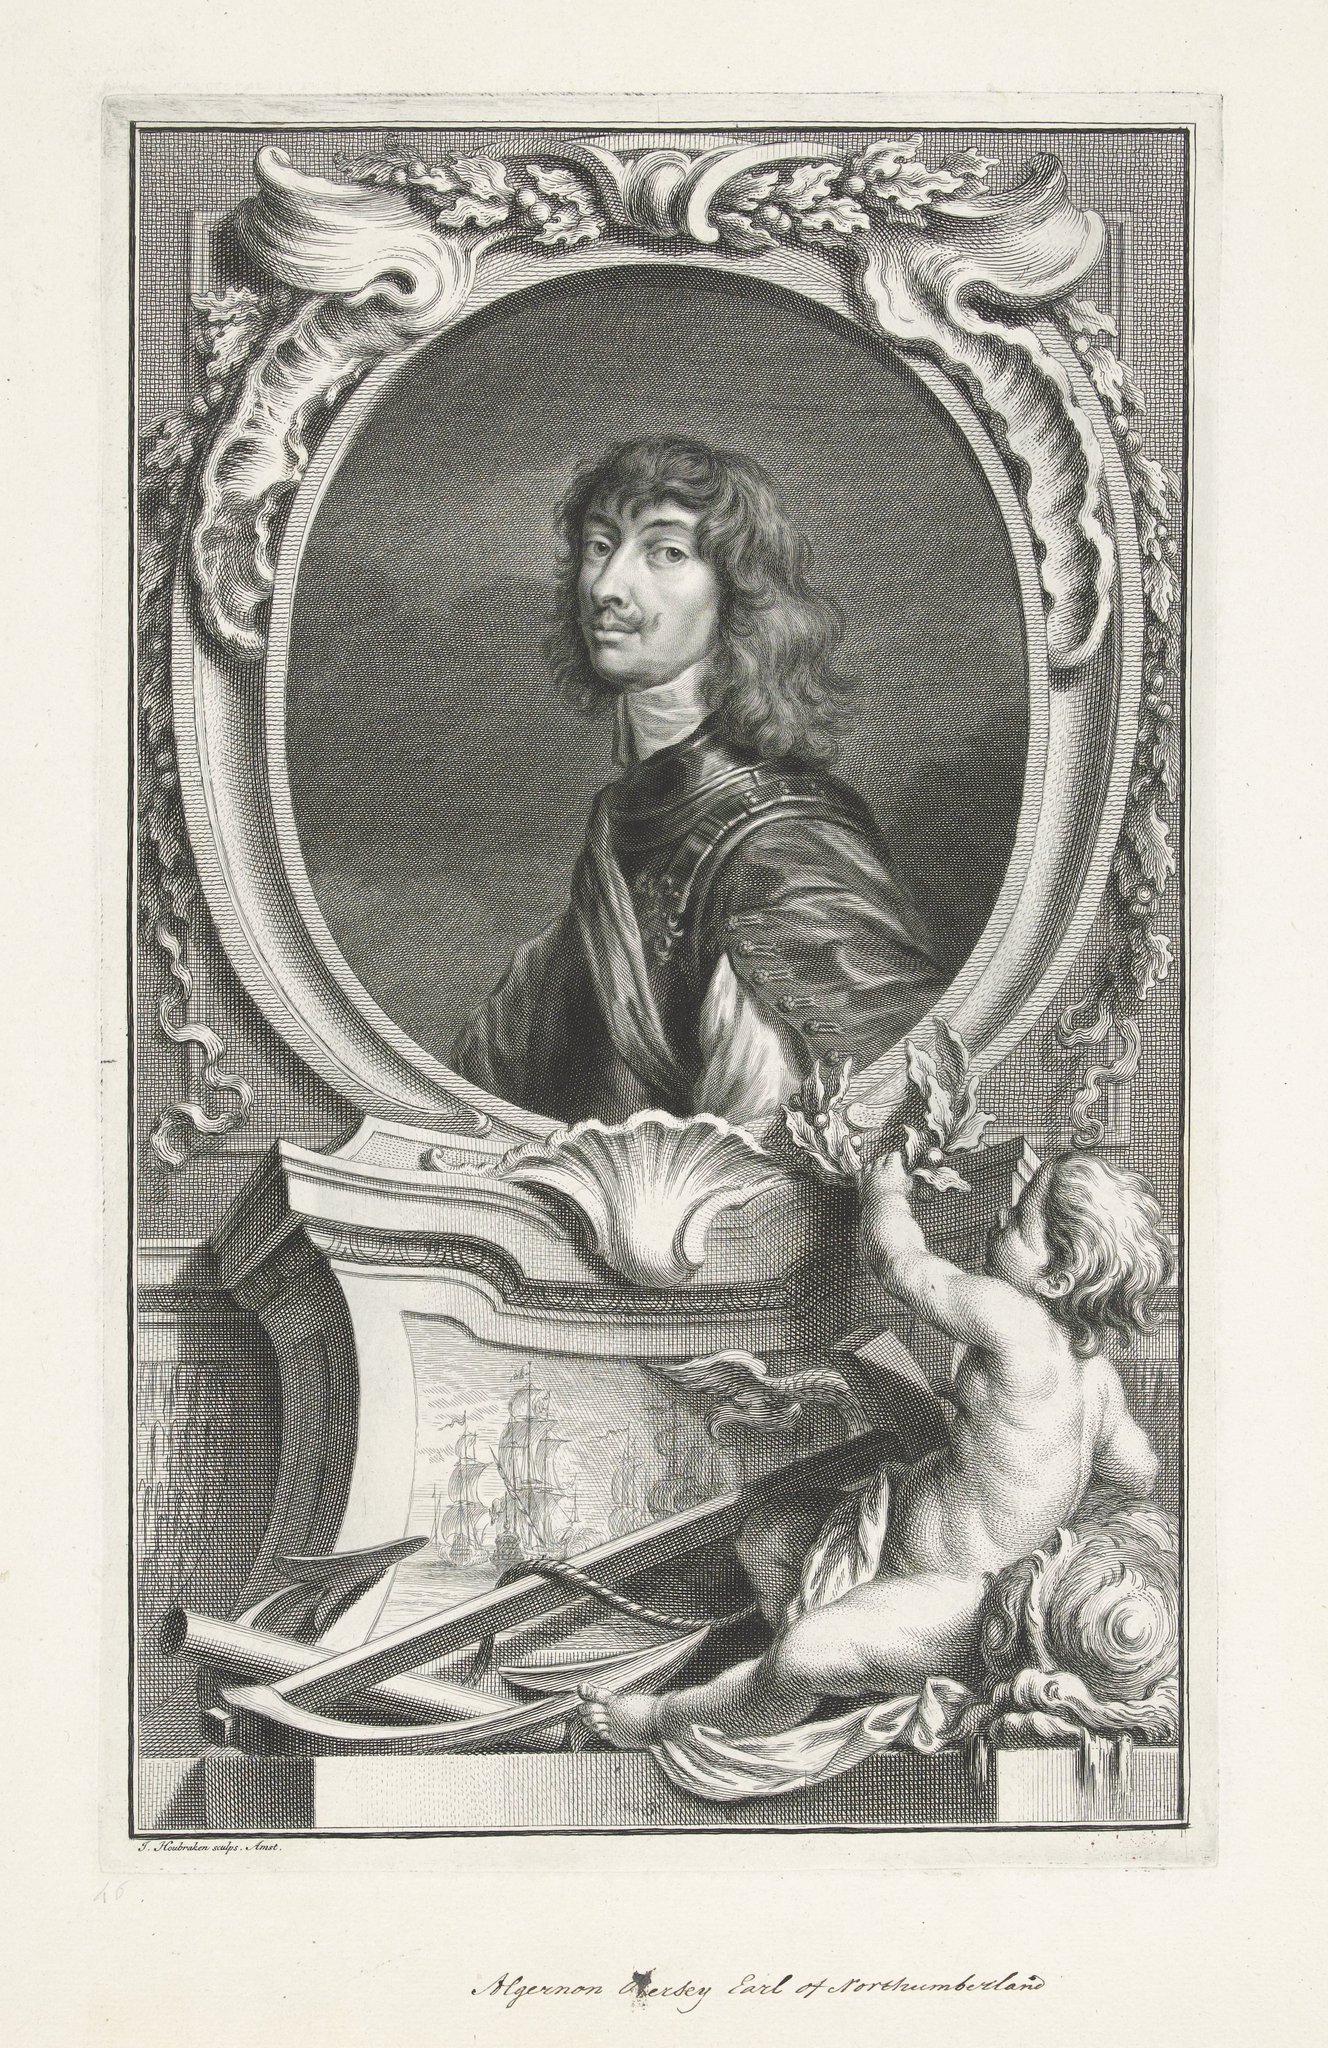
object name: print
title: Portret van Algernon Percy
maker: jacob houbraken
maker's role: draughtsman, print maker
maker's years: 1698-1780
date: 1736-1738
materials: paper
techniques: engraving, etching, pen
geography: amsterdam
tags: algernon percy (10e graaf van northumberland)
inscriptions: name: ‘Algernon Persey Earl of Northumberland’, collector's mark: Lugt 240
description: Prent ook gebruikt in: Thomas Birch. The heads of illustrious persons of Great Britain : engraved by Houbraken, and Vertue, with their lives and characters. London: John en Paul Knapton, 1743-1751.